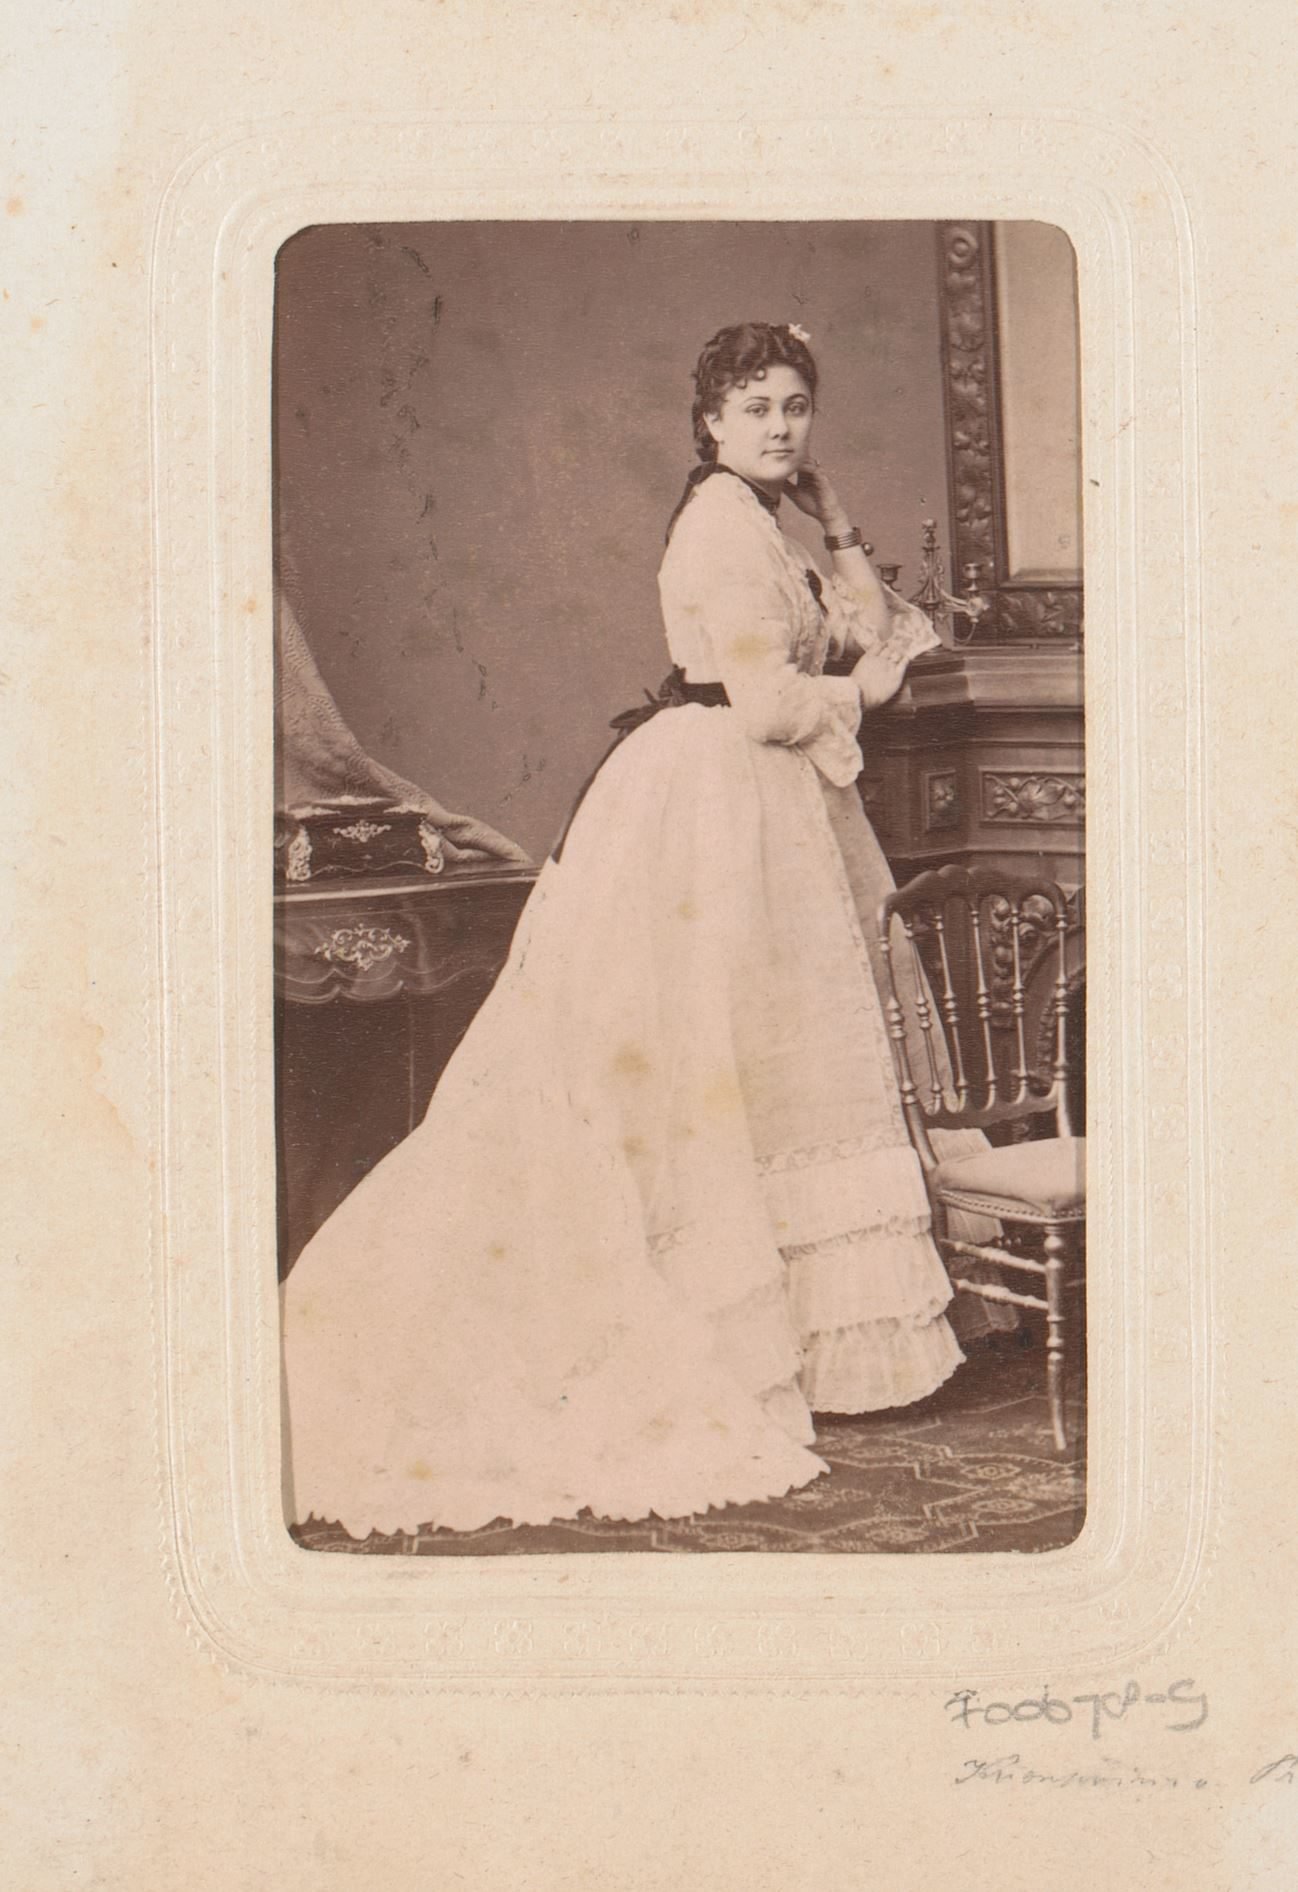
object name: photograph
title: Portret van vermoedelijk Louise Margaretha, prinses van Pruisen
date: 1870-1880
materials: cardboard, photographic support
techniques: albumen print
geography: vienna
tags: prince - bb - female ruler, historical persons - bb - woman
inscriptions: annotation: ‘840 [...]’, inscription: ‘Schrank & Massak/ Stadt, Elisabethstrasse 1/ Wien’